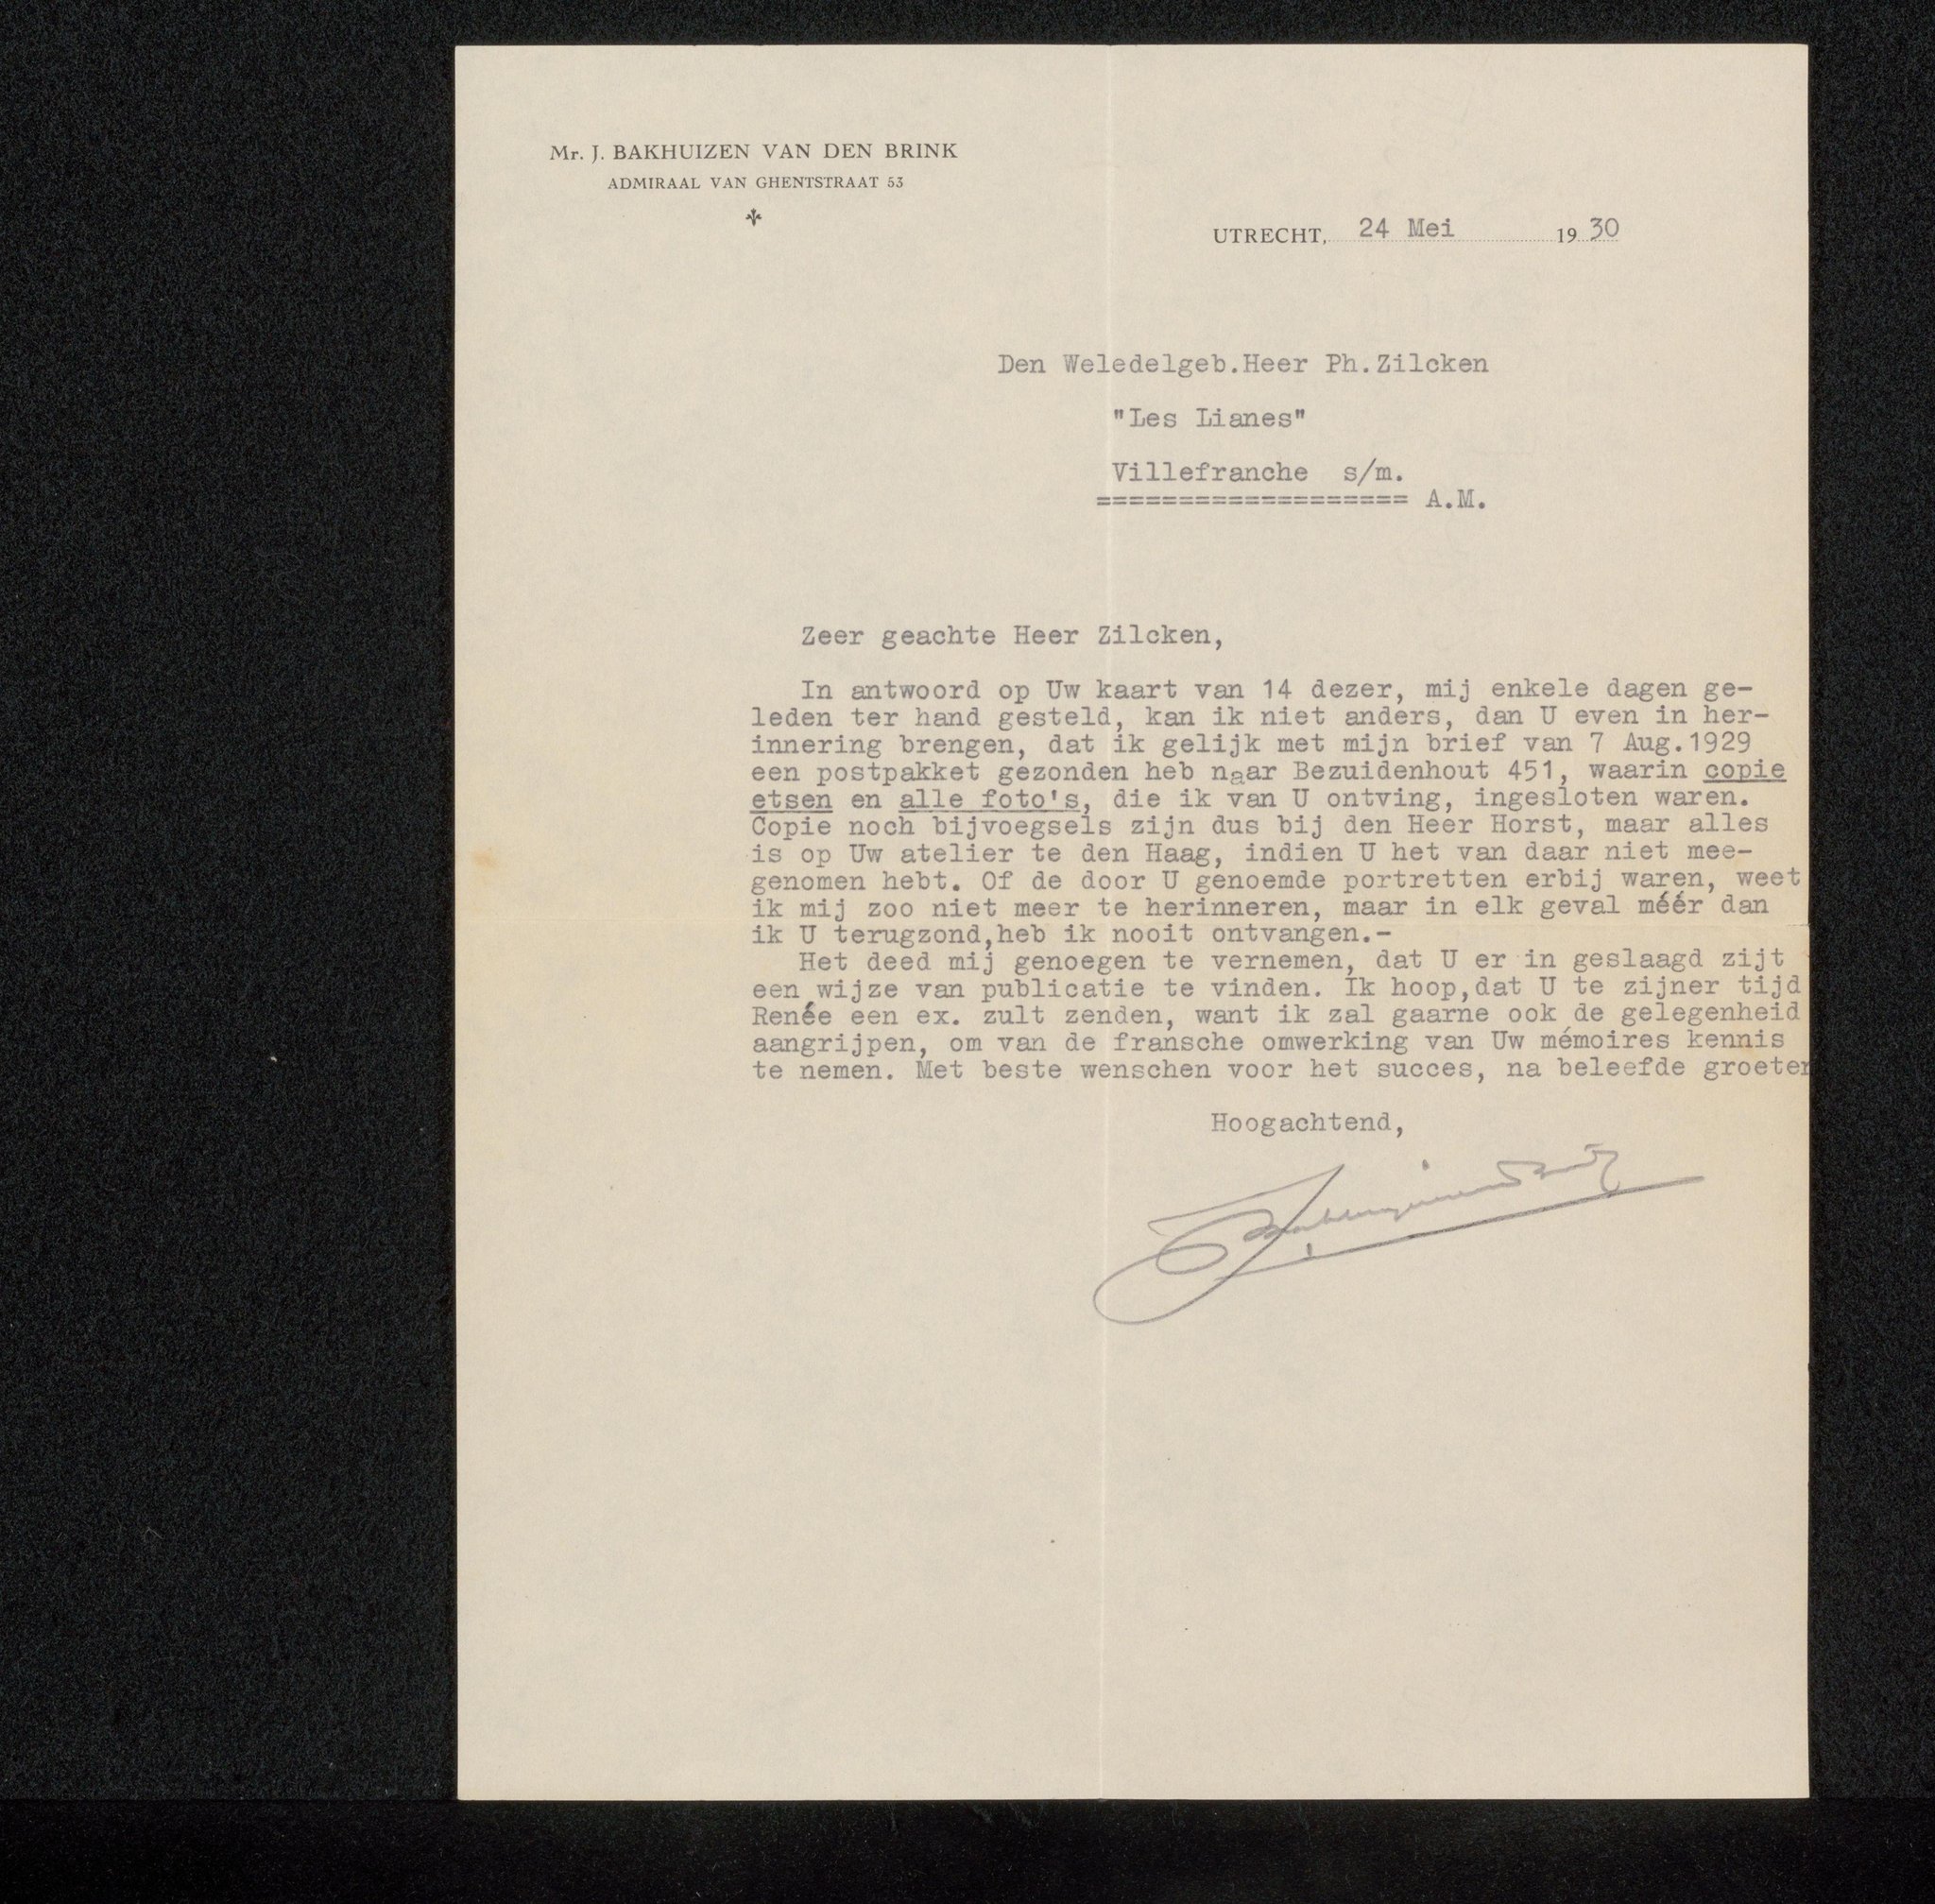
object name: letter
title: Brief aan Philip Zilcken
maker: j. bakhuizen van den brink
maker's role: schrijver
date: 1930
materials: ink, paper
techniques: pen, printing, typewriting, writing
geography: utrecht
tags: painter, draughtsman, philip zilcken, sending and receiving postal matter, photography, cinematography, the graphic arts, workshop, studio of the artist (in general), the hague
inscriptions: collector's mark: ‘RPK’